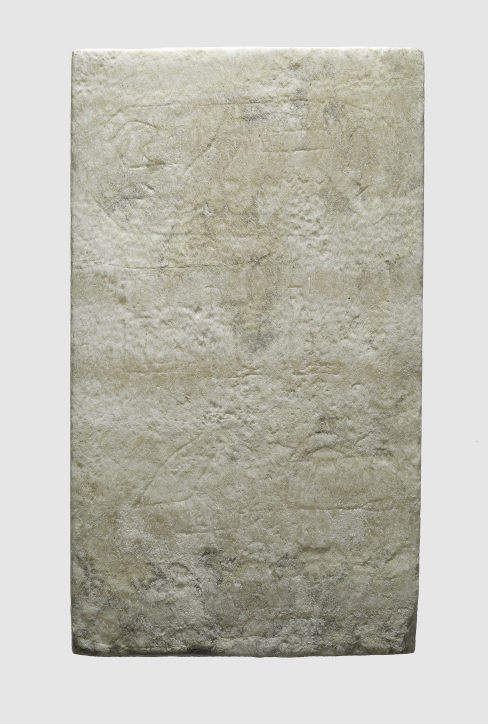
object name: foundation deposit plaque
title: Foundation deposit plaque of Amenemhat I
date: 1981-1952 BCE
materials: stone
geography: egypt